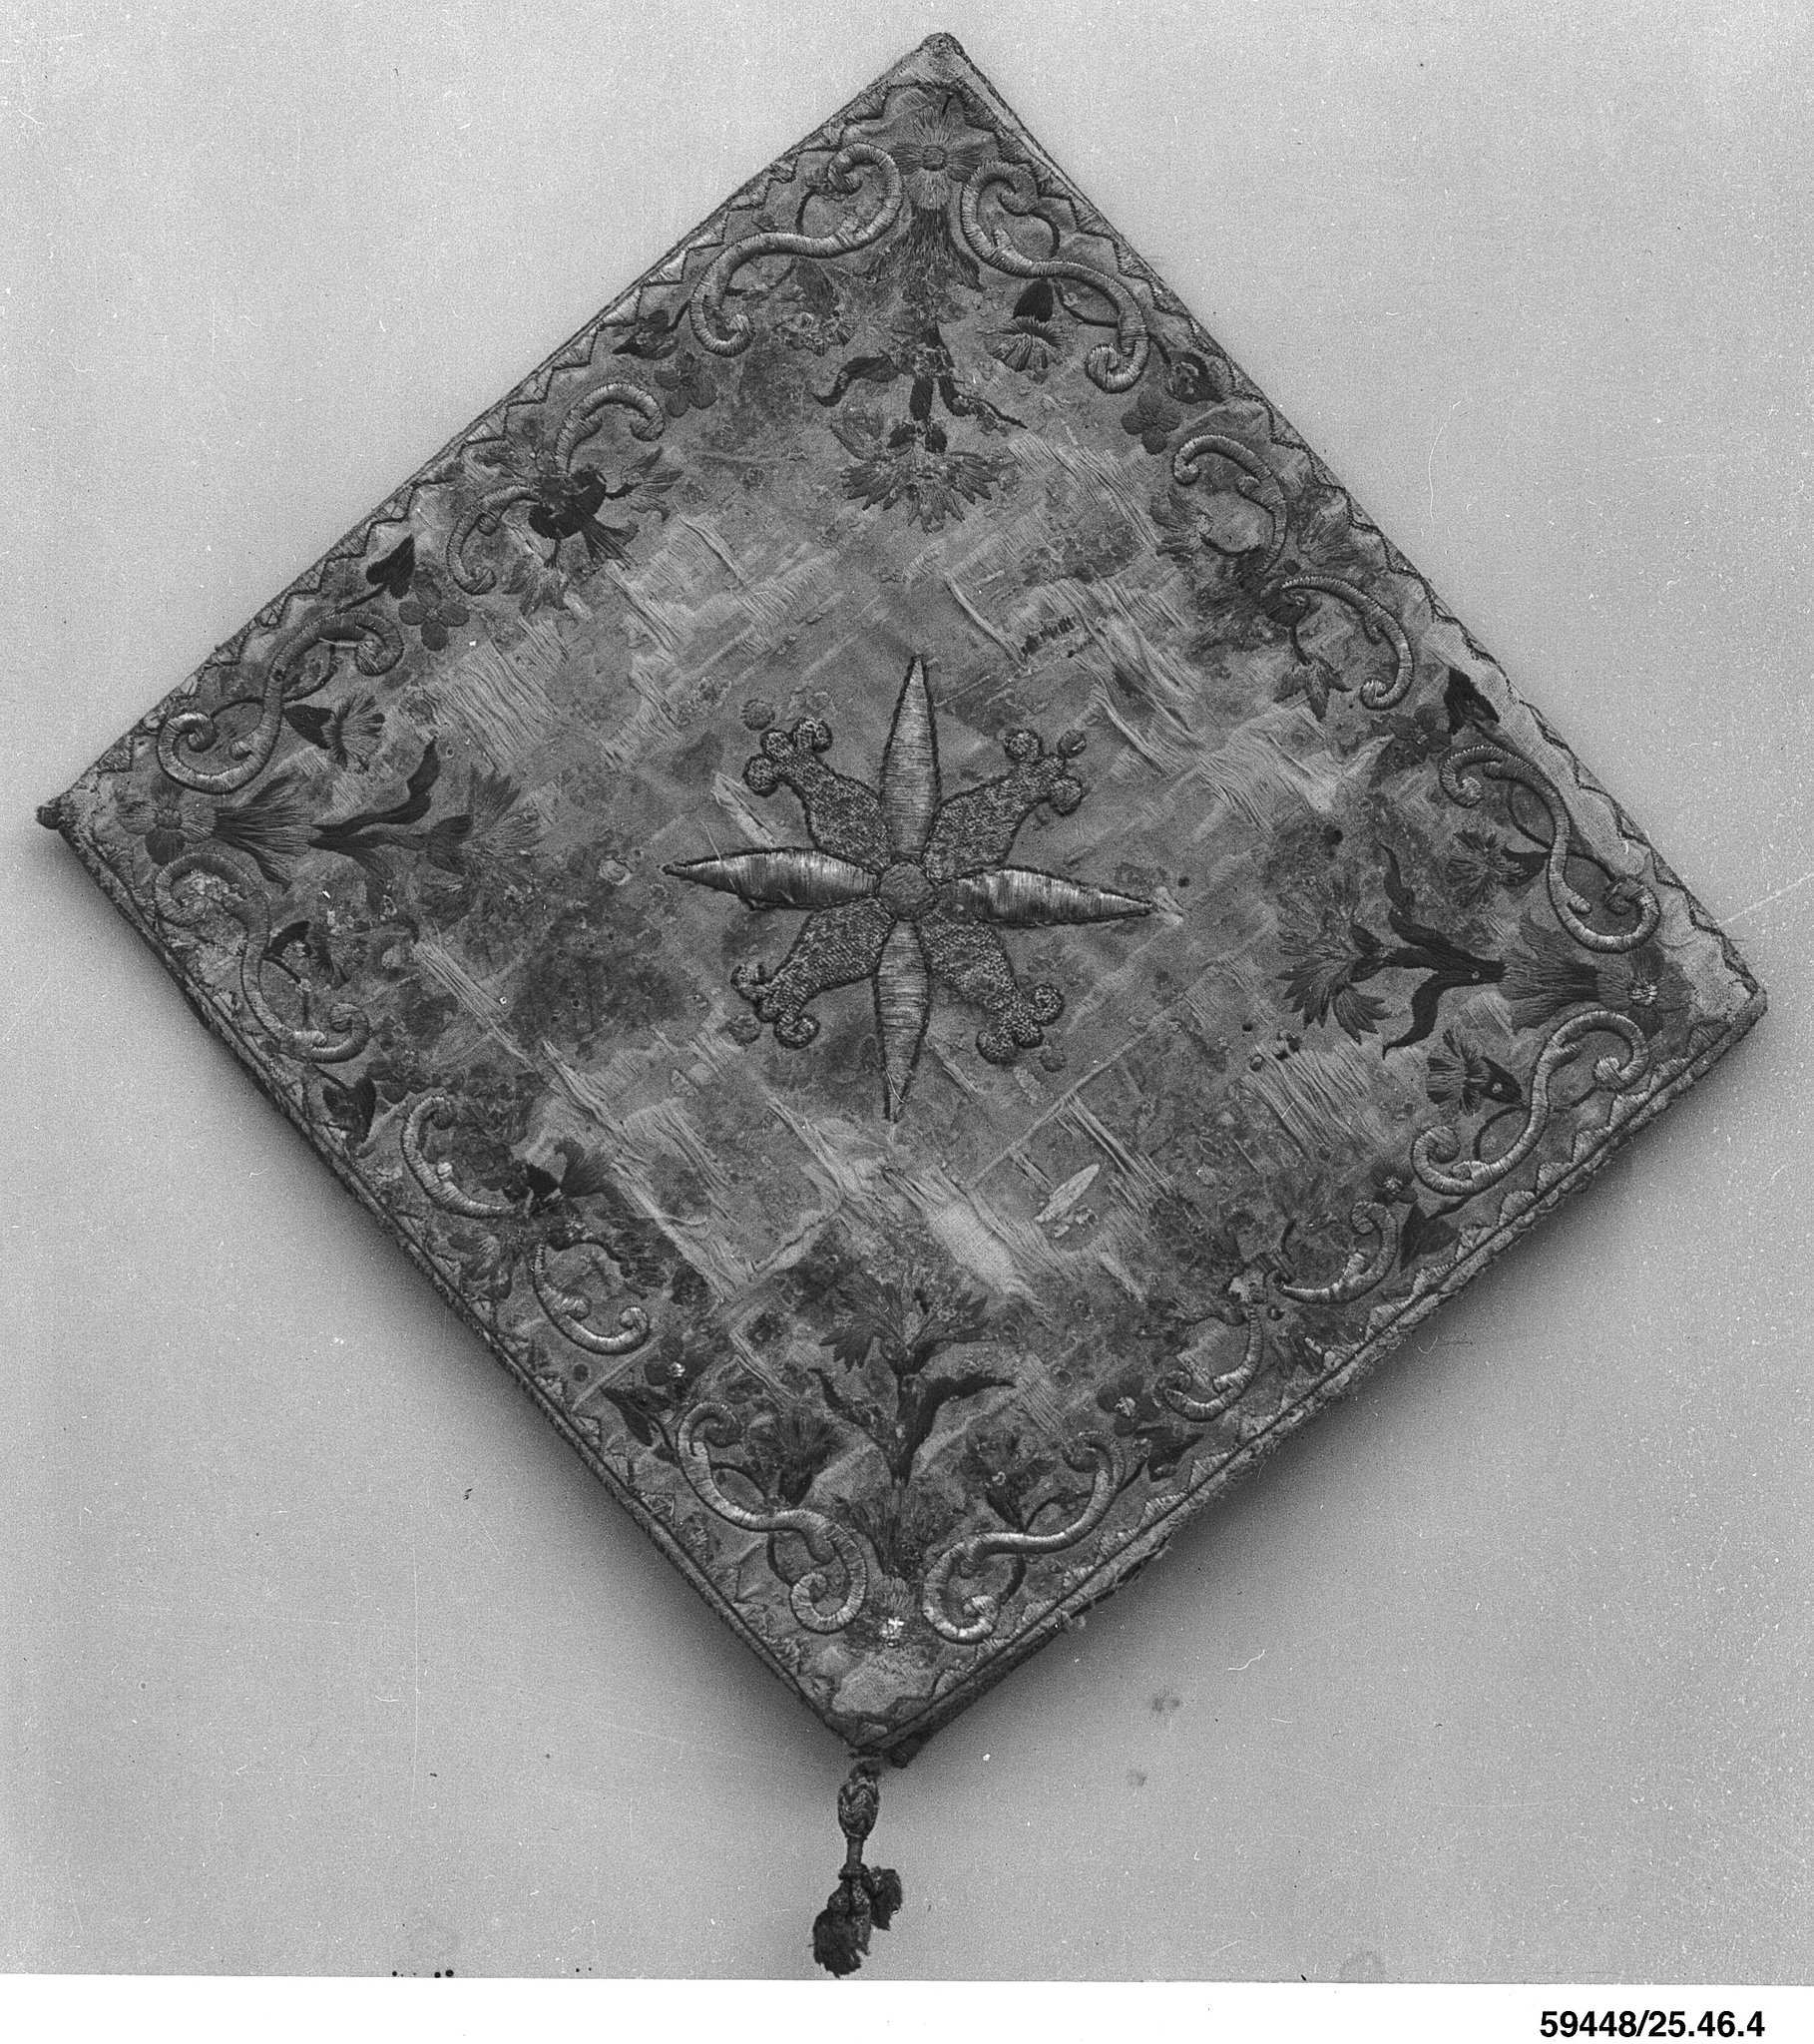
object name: burse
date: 1700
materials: metal thread, silk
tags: flowers